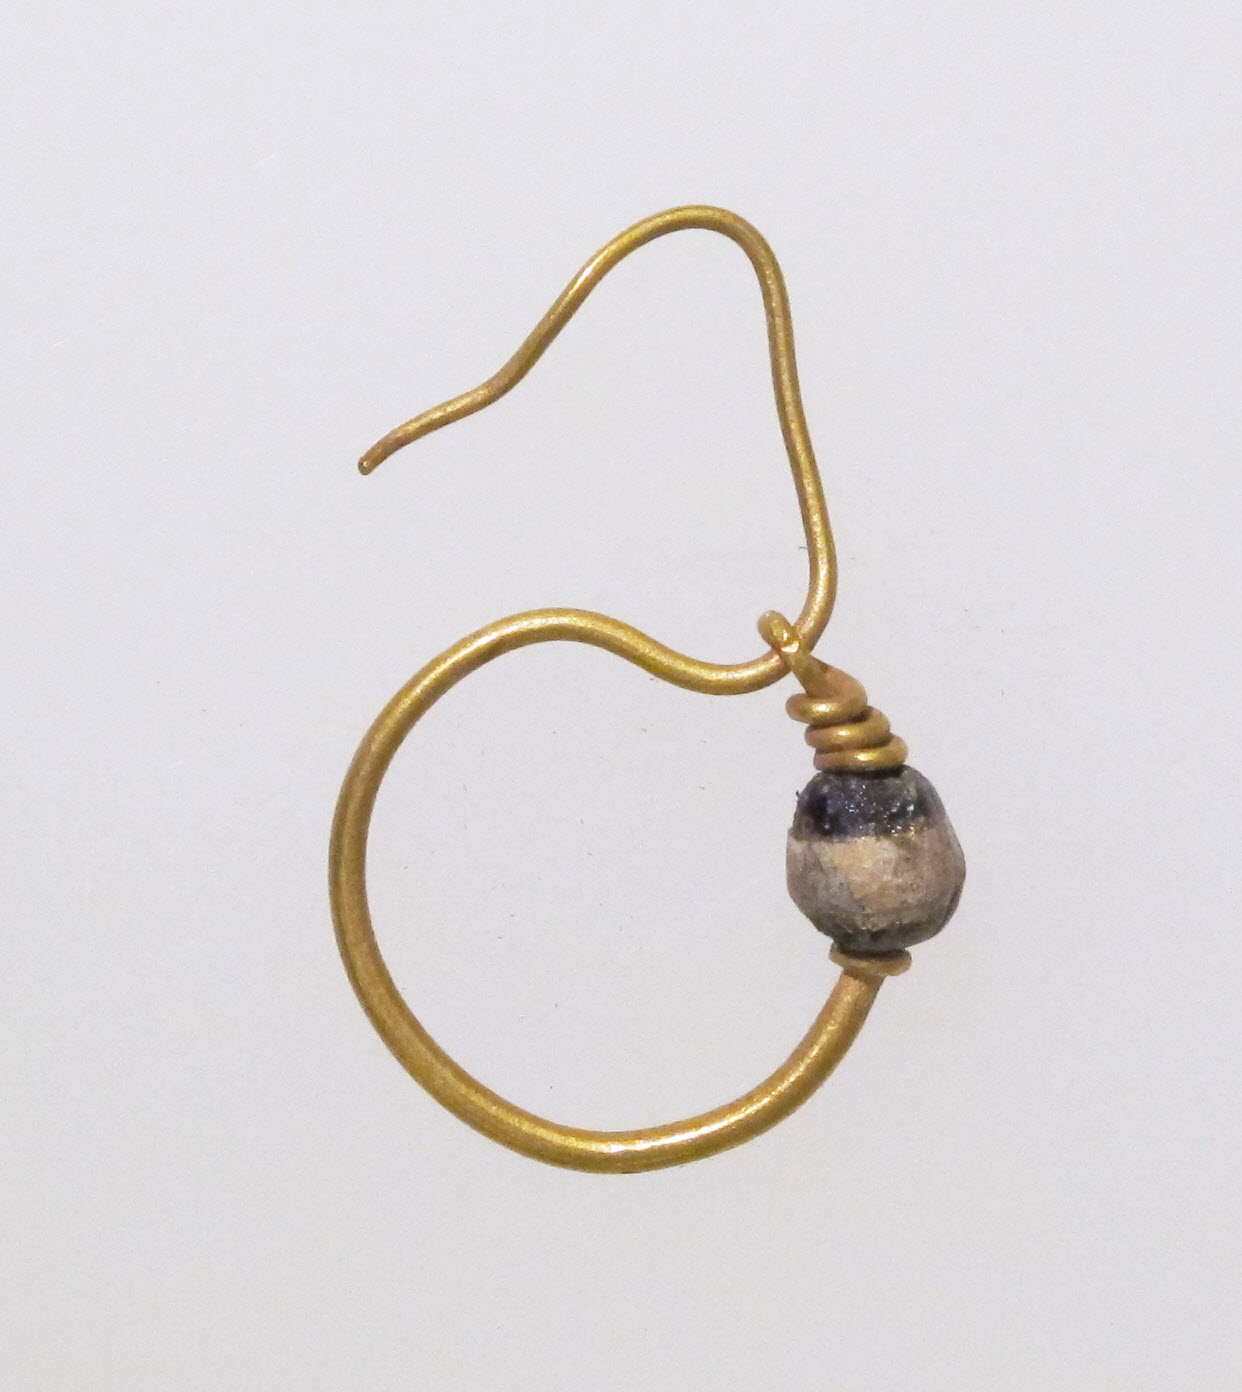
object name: earring, delta shaped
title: Earring, delta-shaped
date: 7000 BCE-330 CE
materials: gold